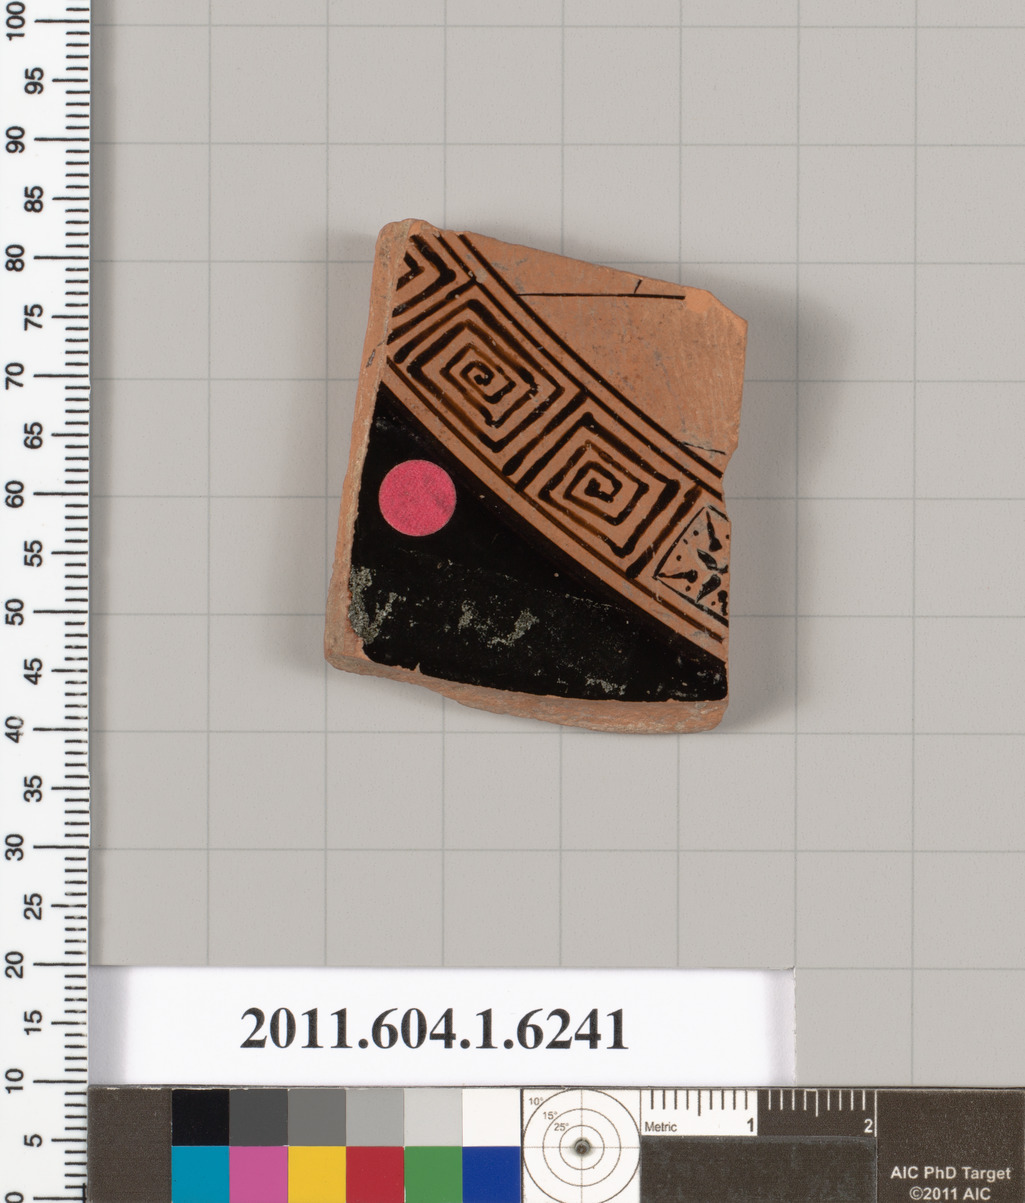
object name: kylix fragment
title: Terracotta fragment of a kylix (drinking cup)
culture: greek, attic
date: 534-468 BCE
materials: terracotta